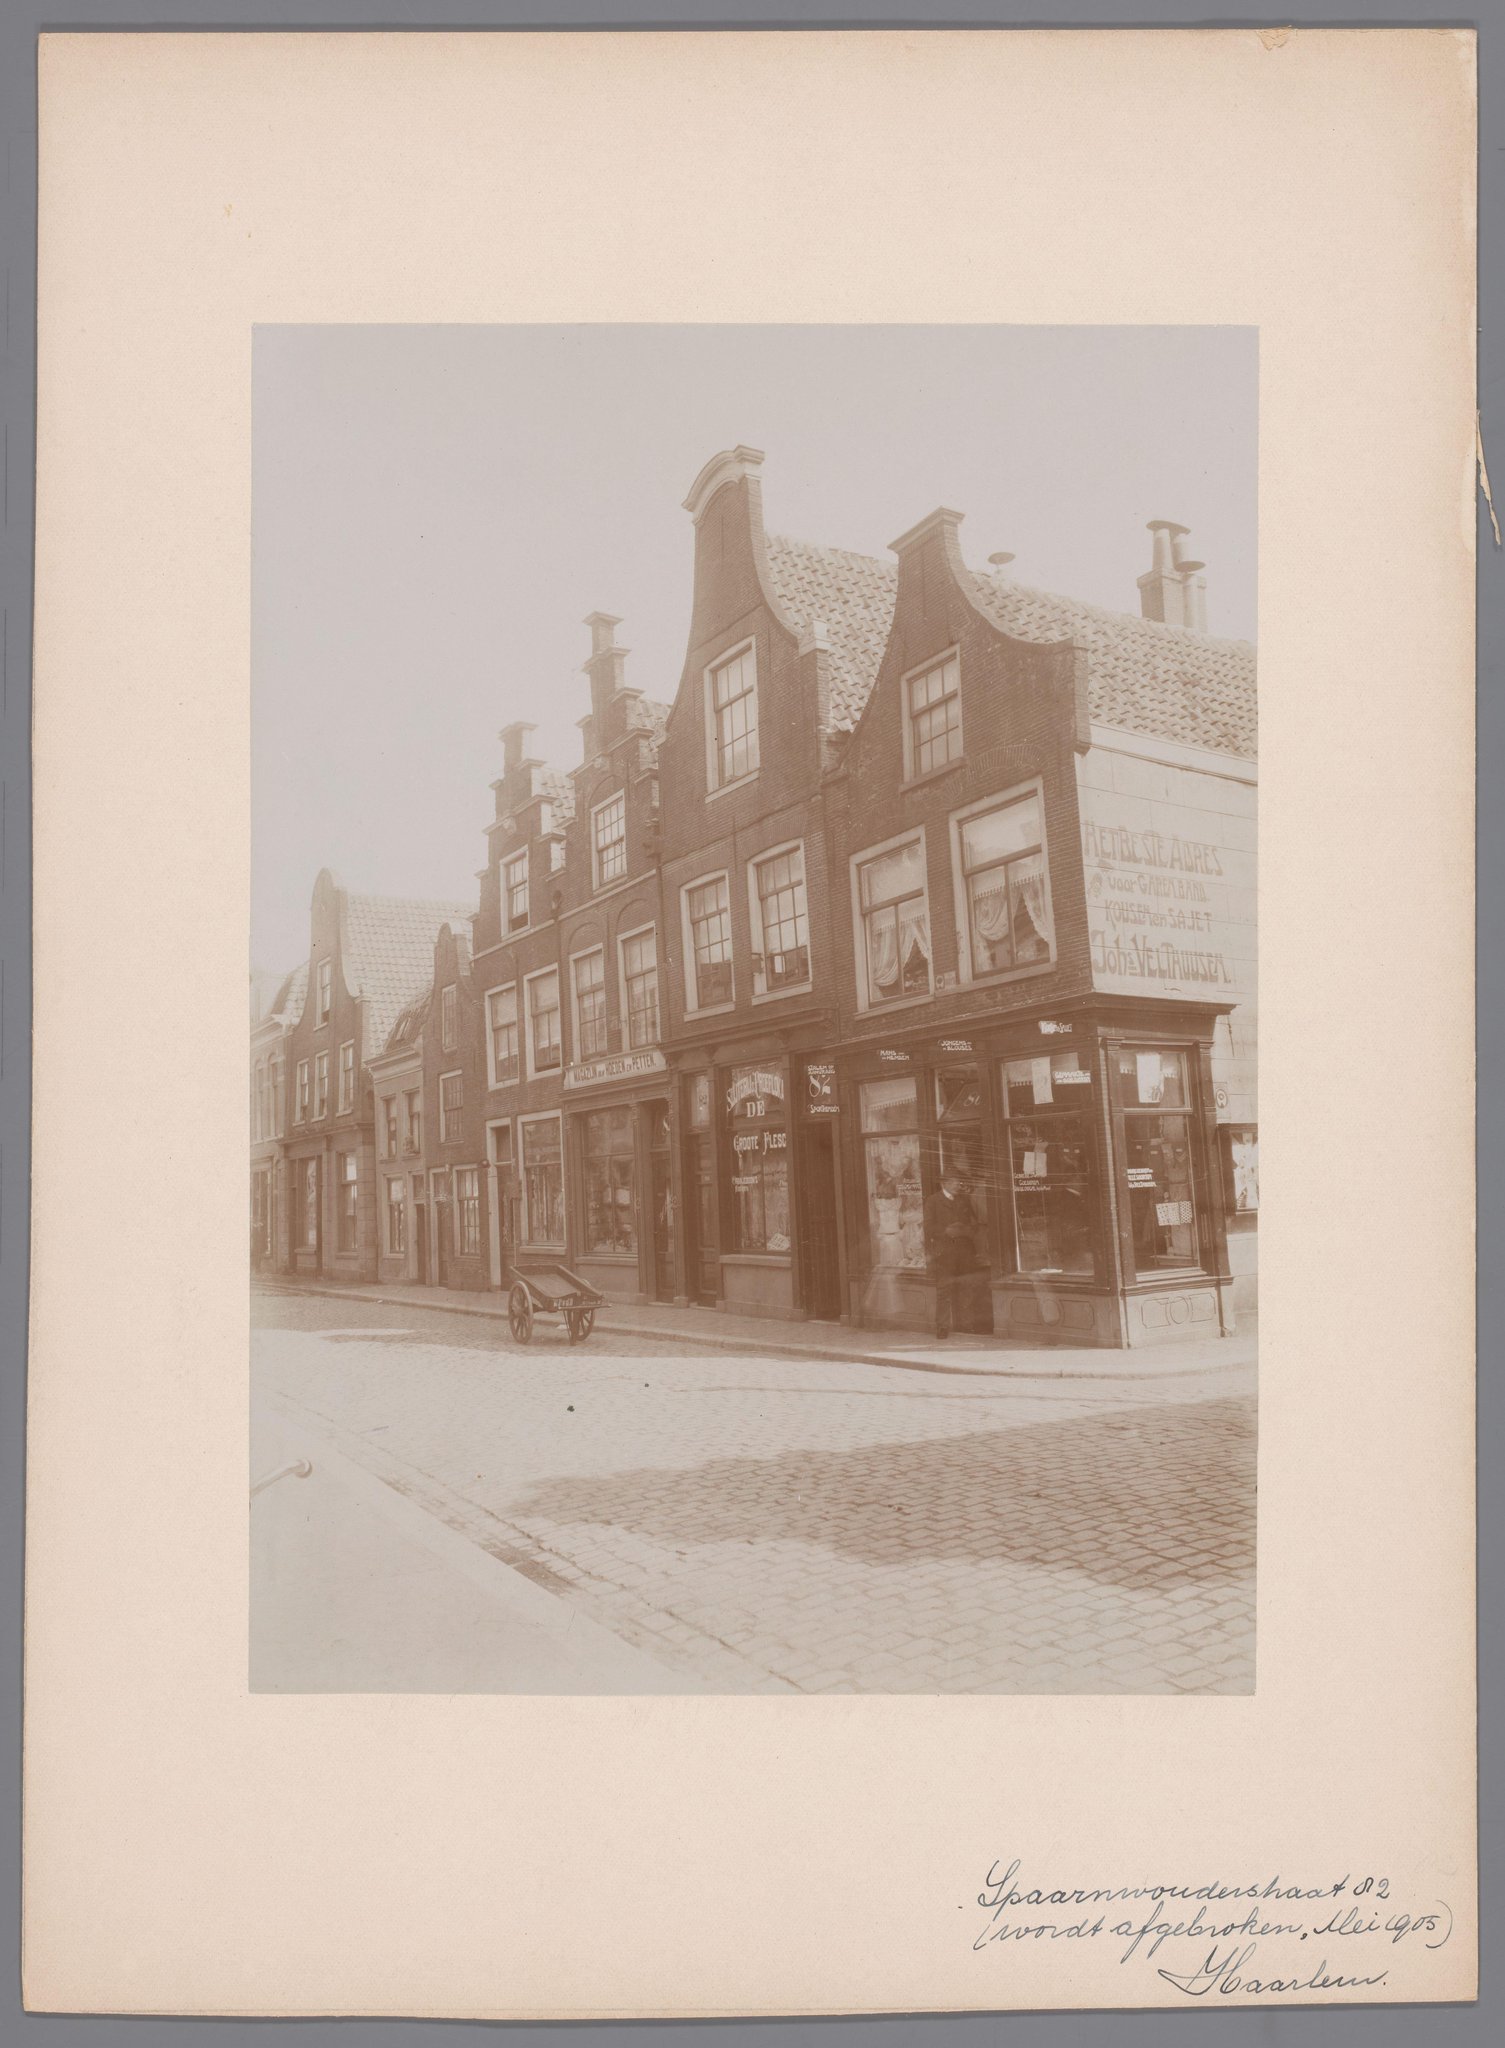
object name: photograph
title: Gezicht op de Spaarnwouderstraat te Haarlem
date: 1905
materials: cardboard, photographic support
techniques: collodion silver print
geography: spaarnwouderstraat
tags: shop, store, façade (of house or building), street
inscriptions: annotation: ‘Spaarnwouderstraat 82 (wordt afgebroken, Mei 1905)/ Haarlem’, annotation: ‘Haarlem (N.H.)/ Spaarnwouderstraat N:82 wordt afgebroken/ Mei 1905’